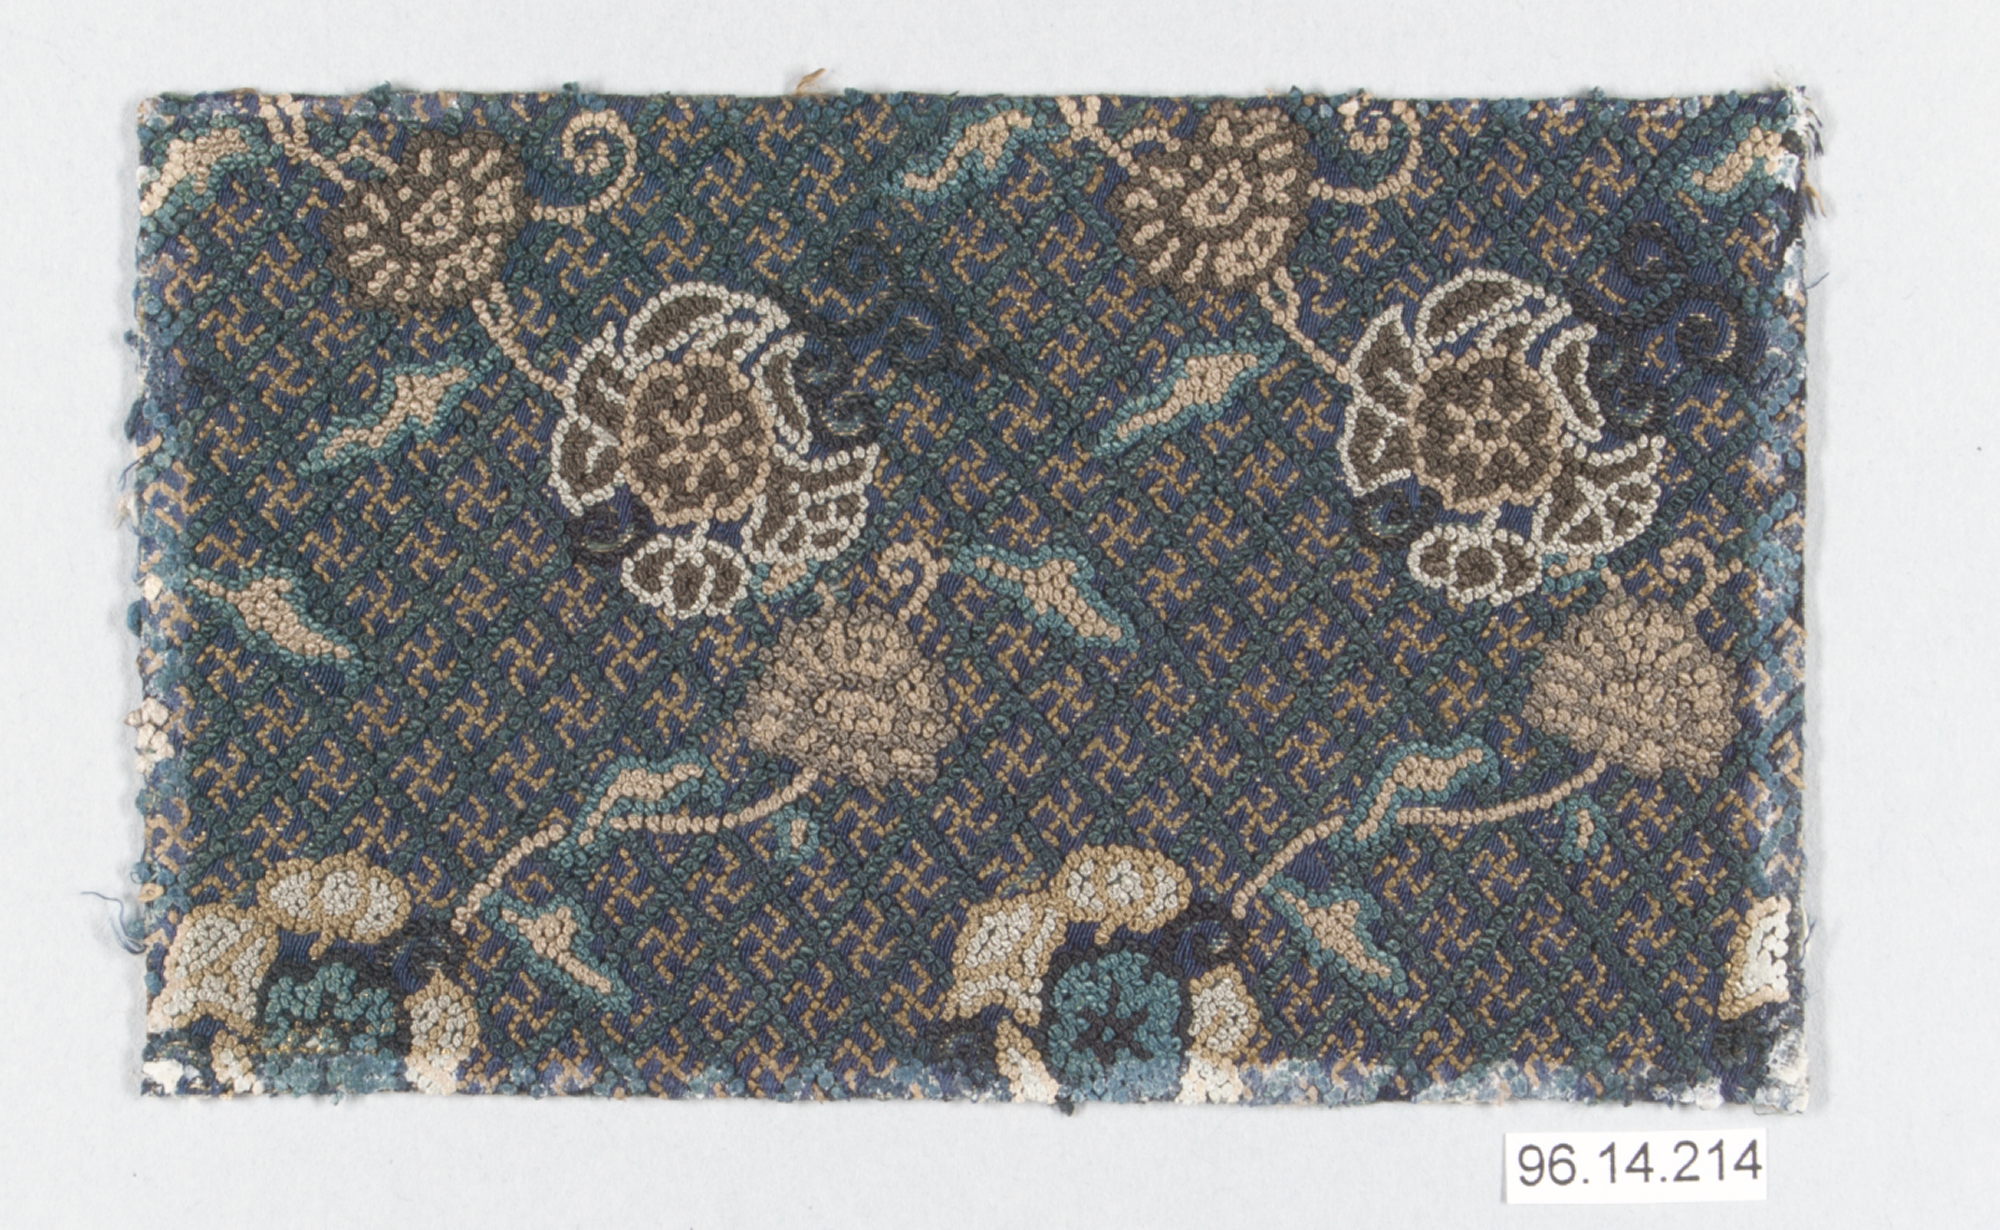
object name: piece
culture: japanese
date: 1701-1900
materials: silk